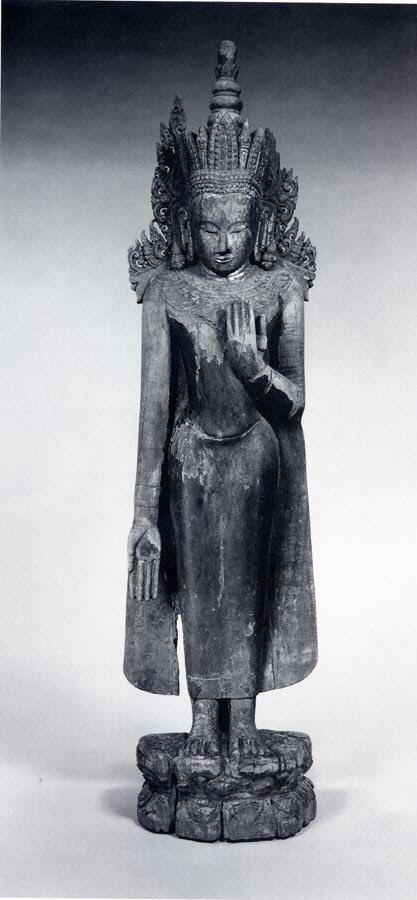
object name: statue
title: Crowned Buddha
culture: burmese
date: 1201-1333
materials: gilt, lacquer, wood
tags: buddhism,buddha,crowns